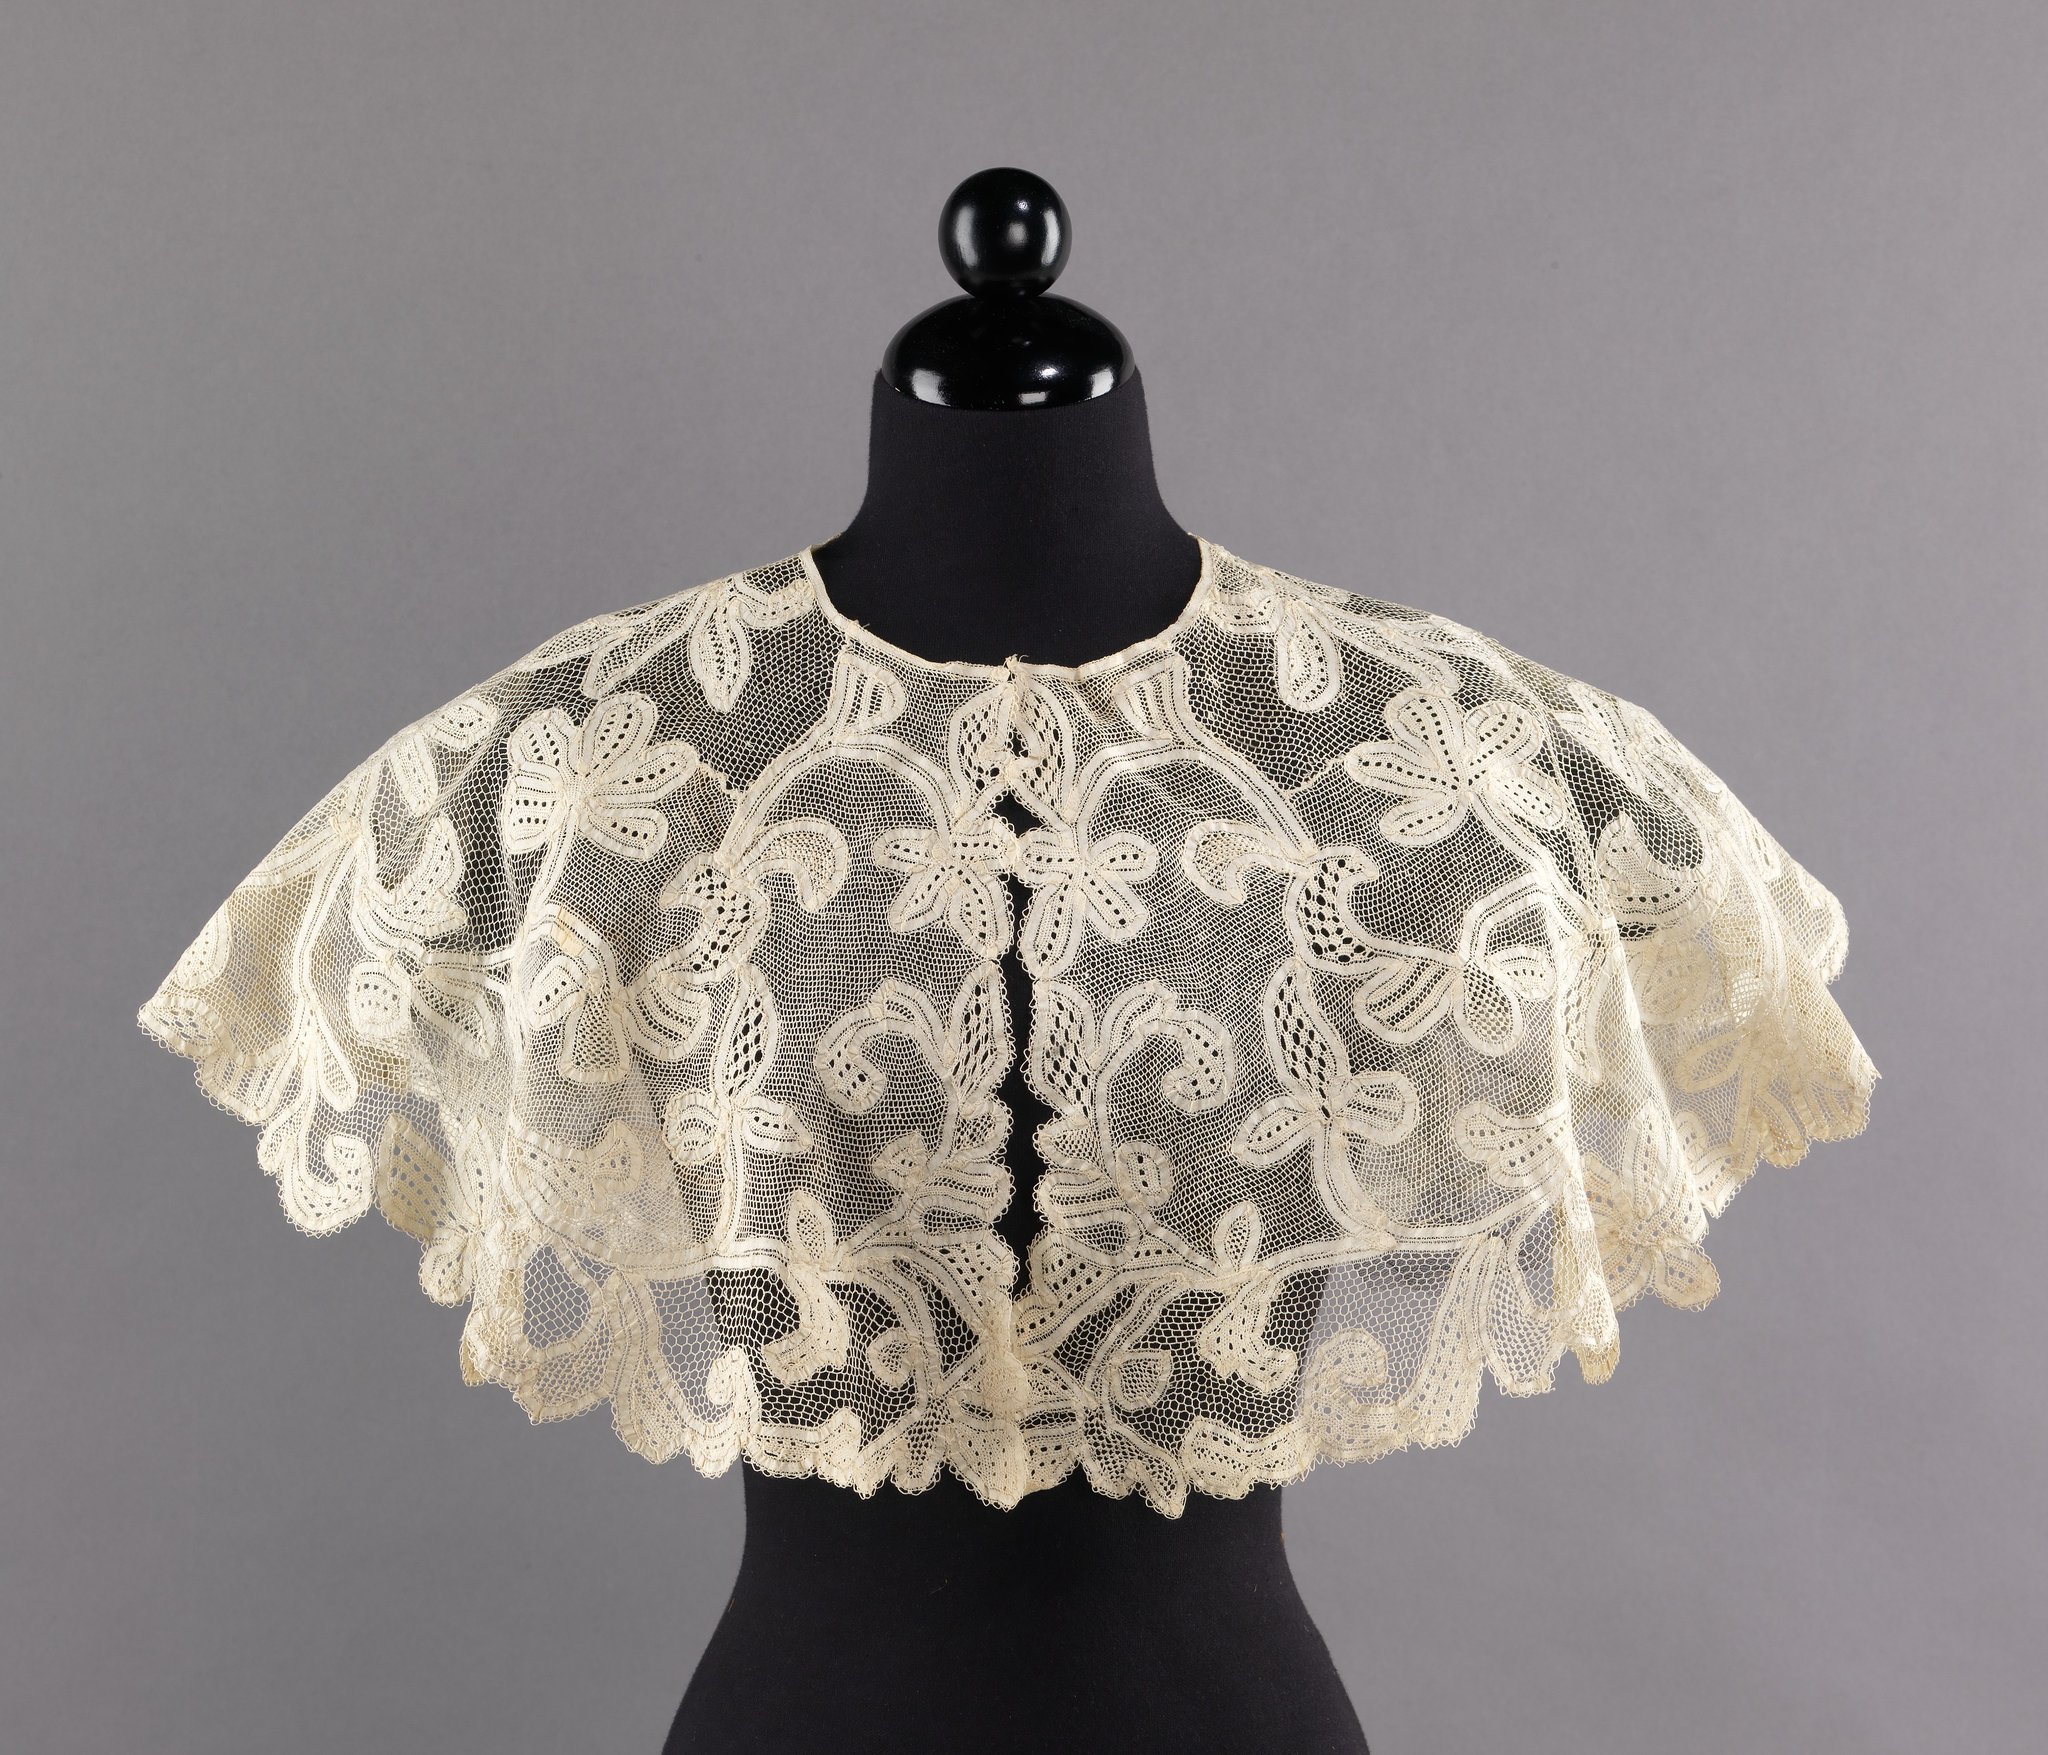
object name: bertha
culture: italian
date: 1895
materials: linen